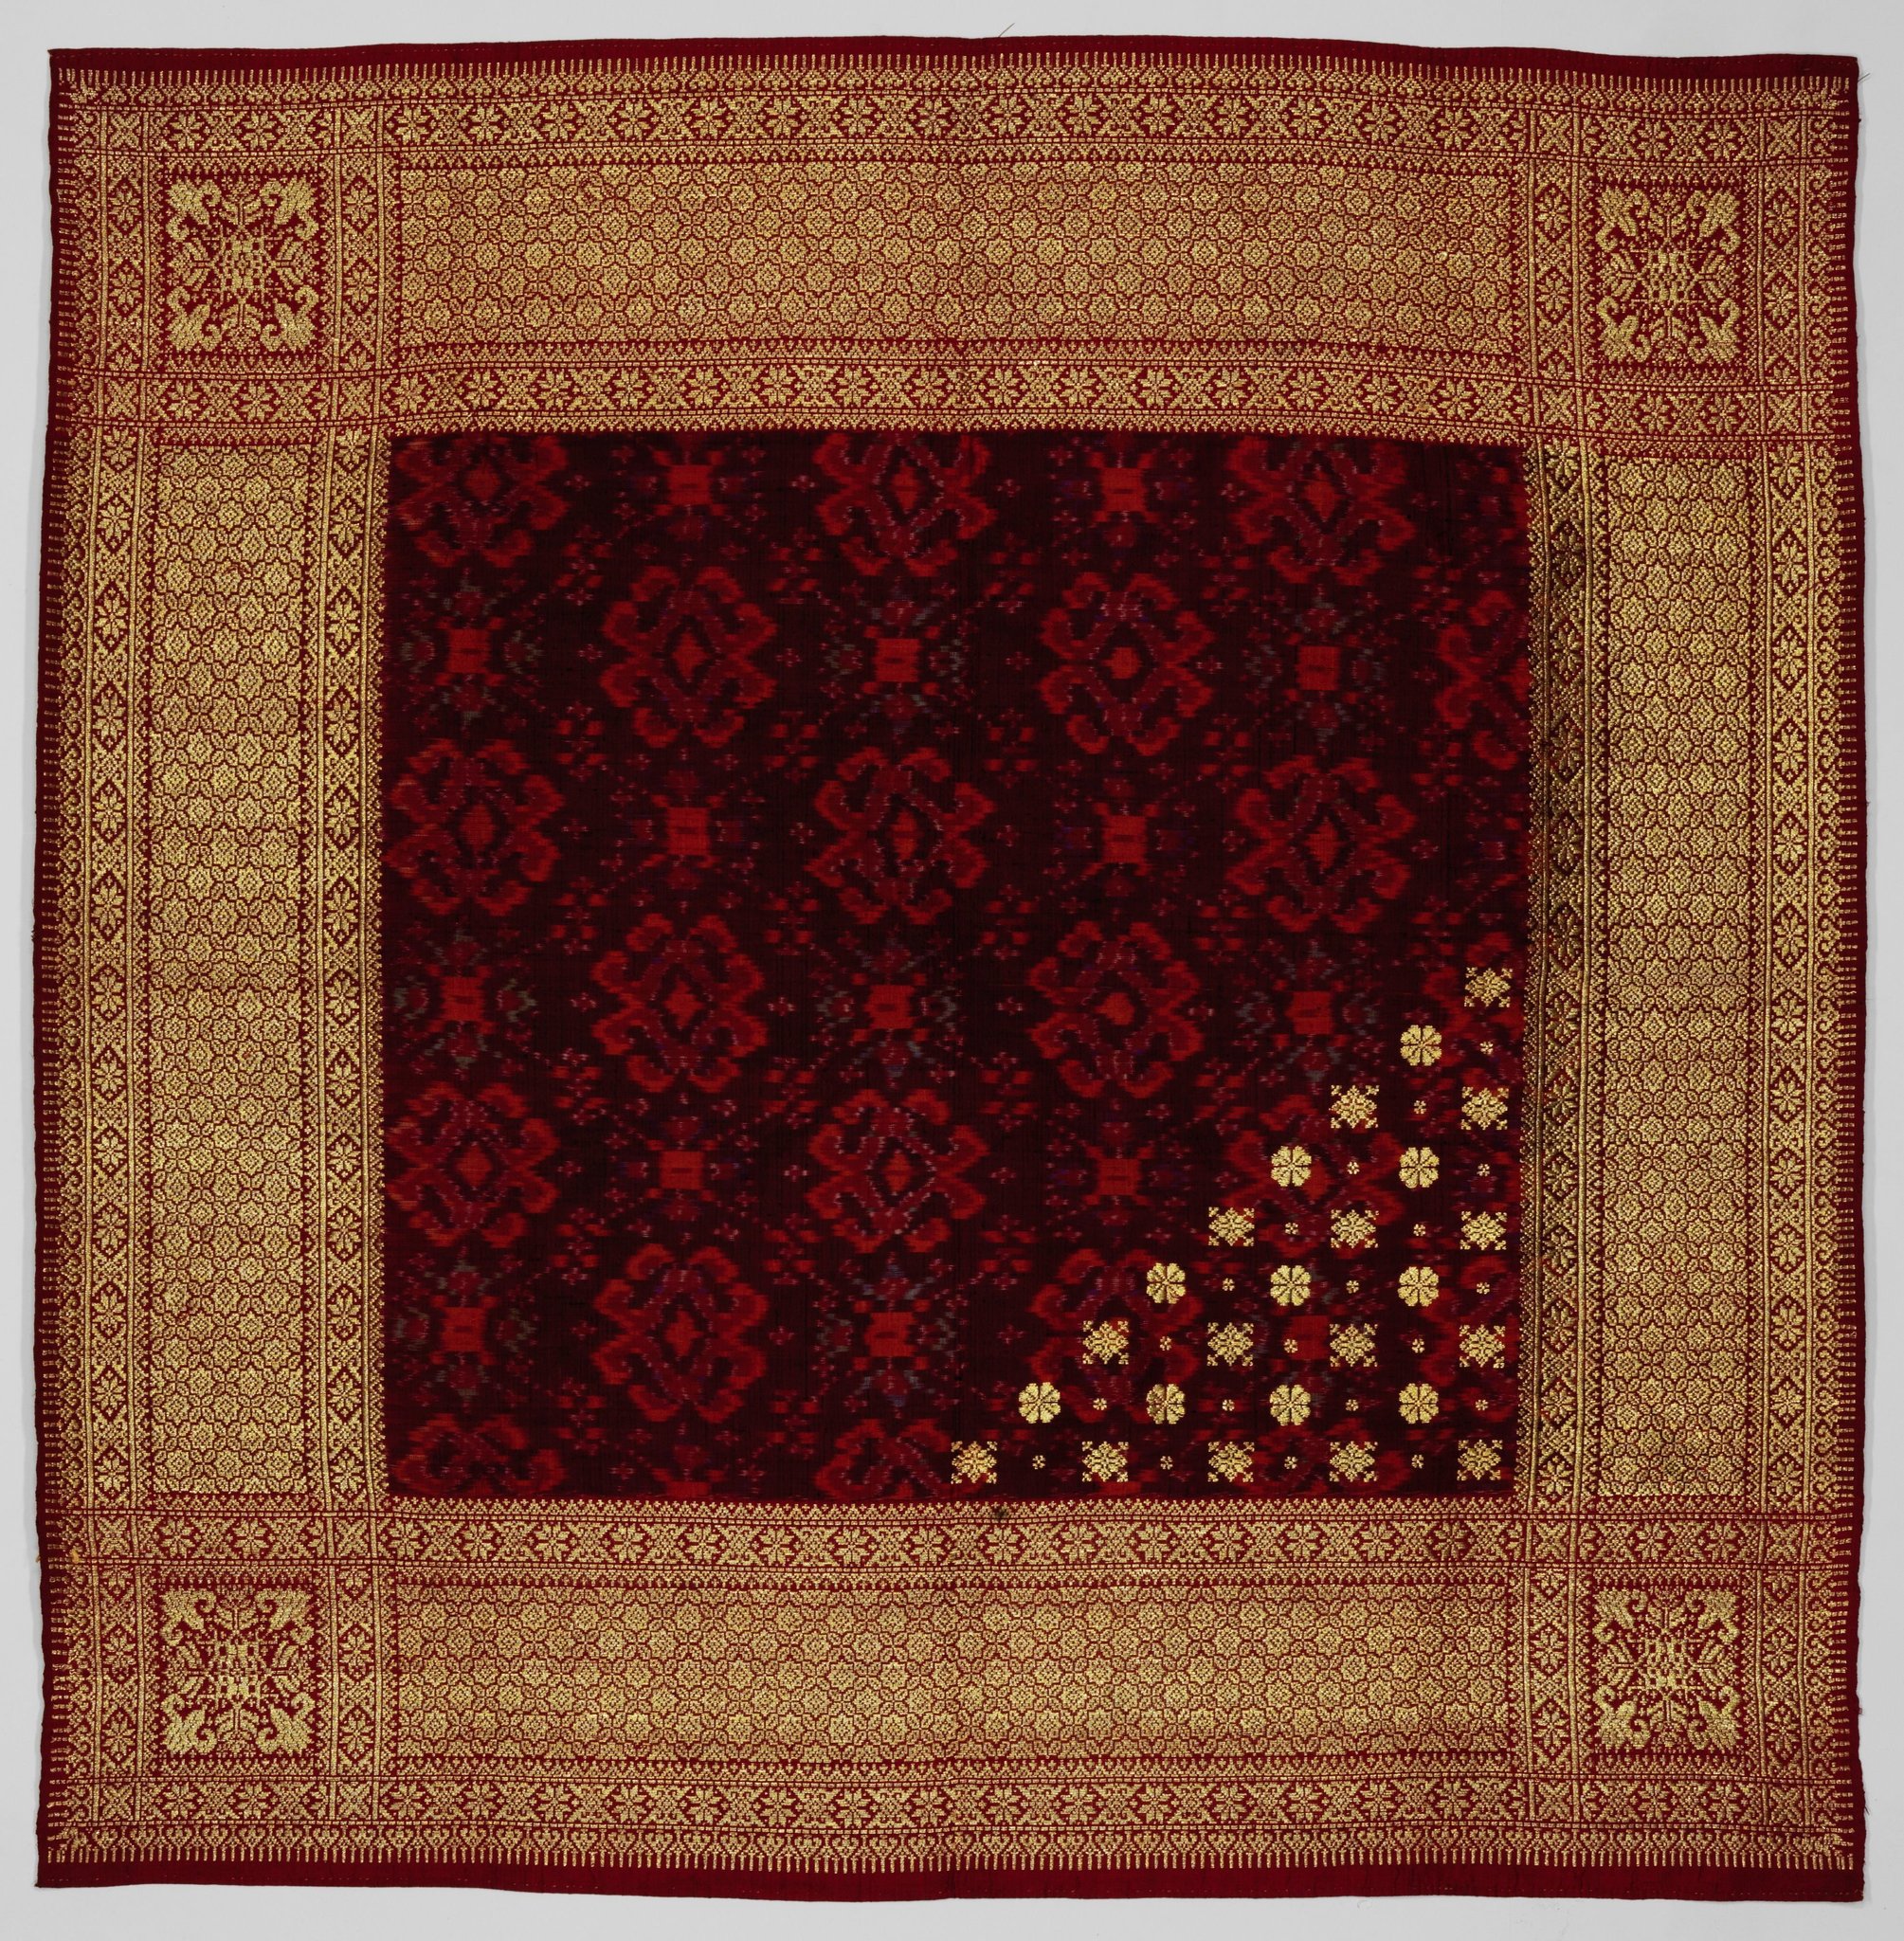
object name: head cloth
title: Setangan lepus limar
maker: Anonymous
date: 1900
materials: gold thread, silk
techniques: weave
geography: south sumatra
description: Hoofddoek met florale en geometrische motieven.